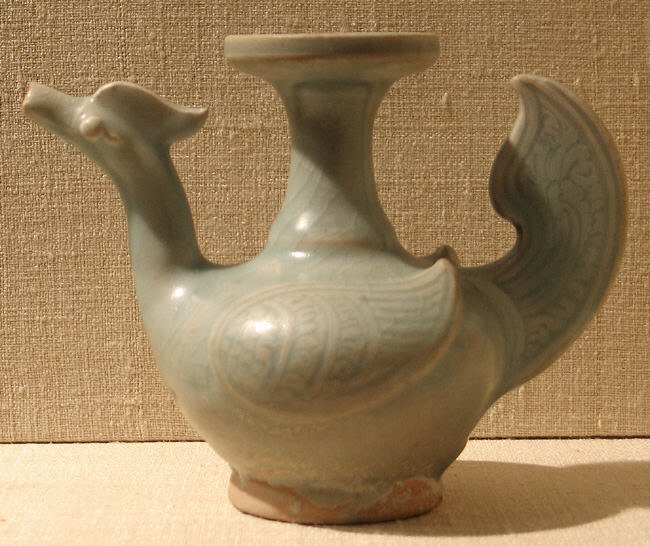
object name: kendi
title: Kendi in the Form of a Hamsa (Gander)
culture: thai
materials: earthenware, glaze, iron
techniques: underglaze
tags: birds